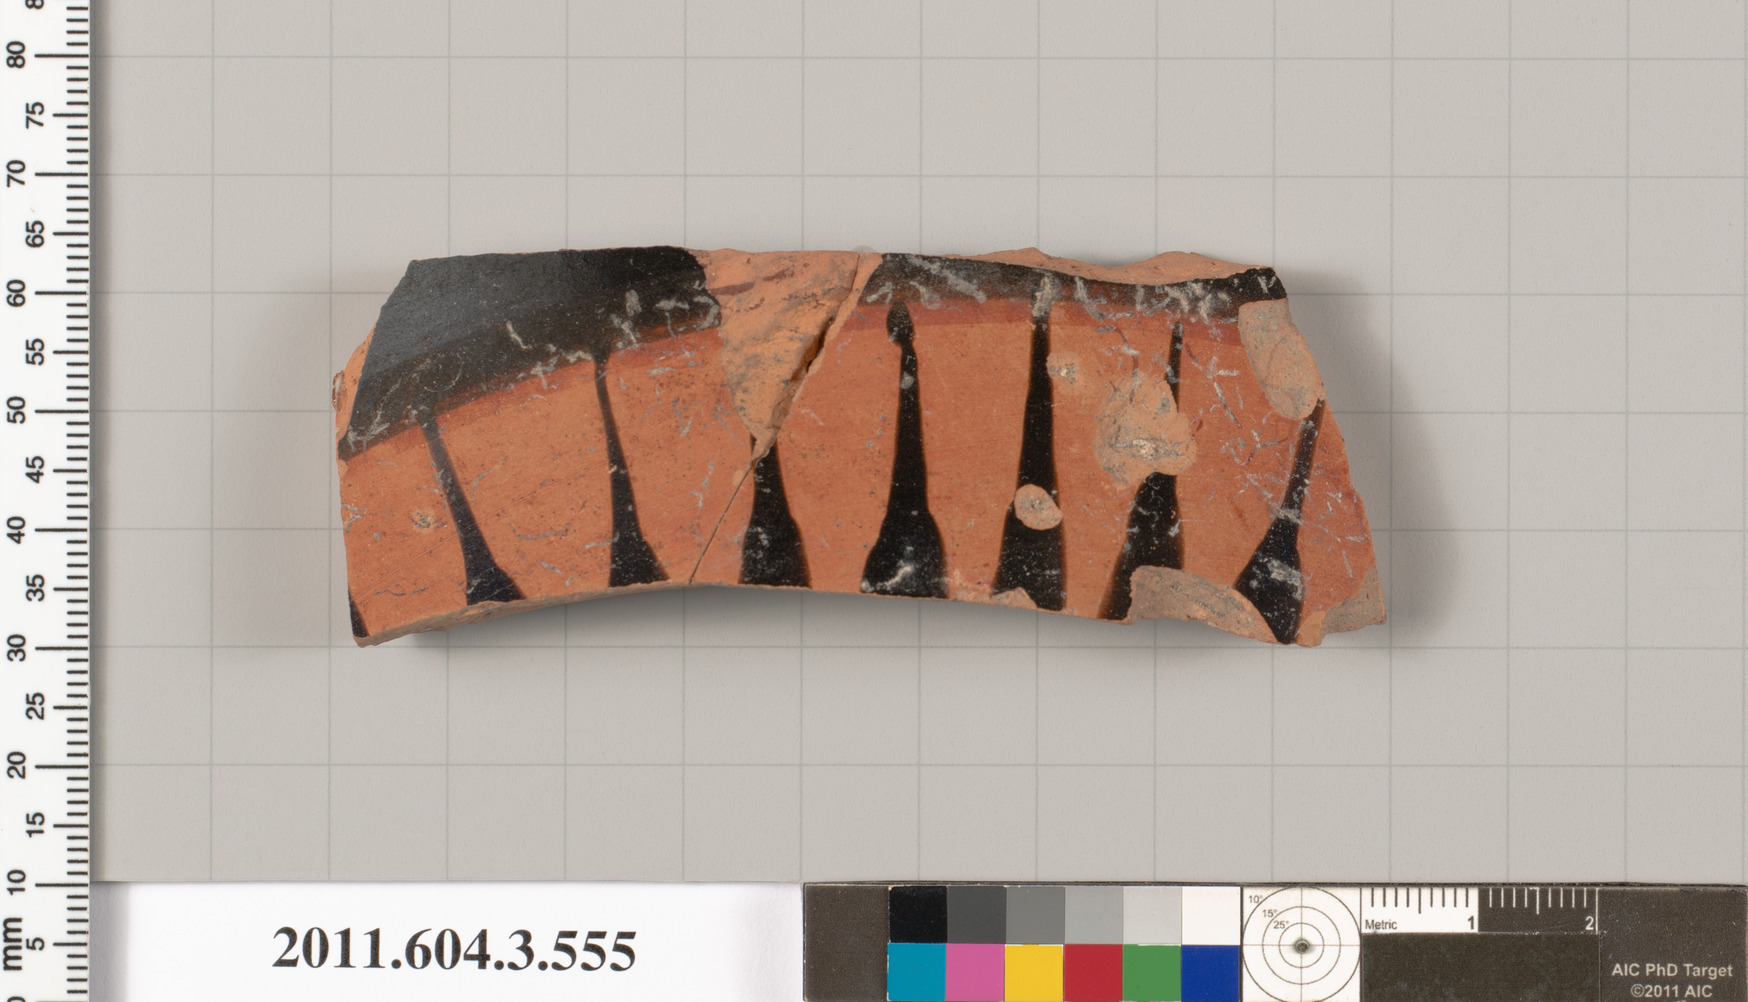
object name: column krater fragment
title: Terracotta fragment of a column-krater (bowl for mixing wine and water)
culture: greek, attic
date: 600-401 BCE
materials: terracotta